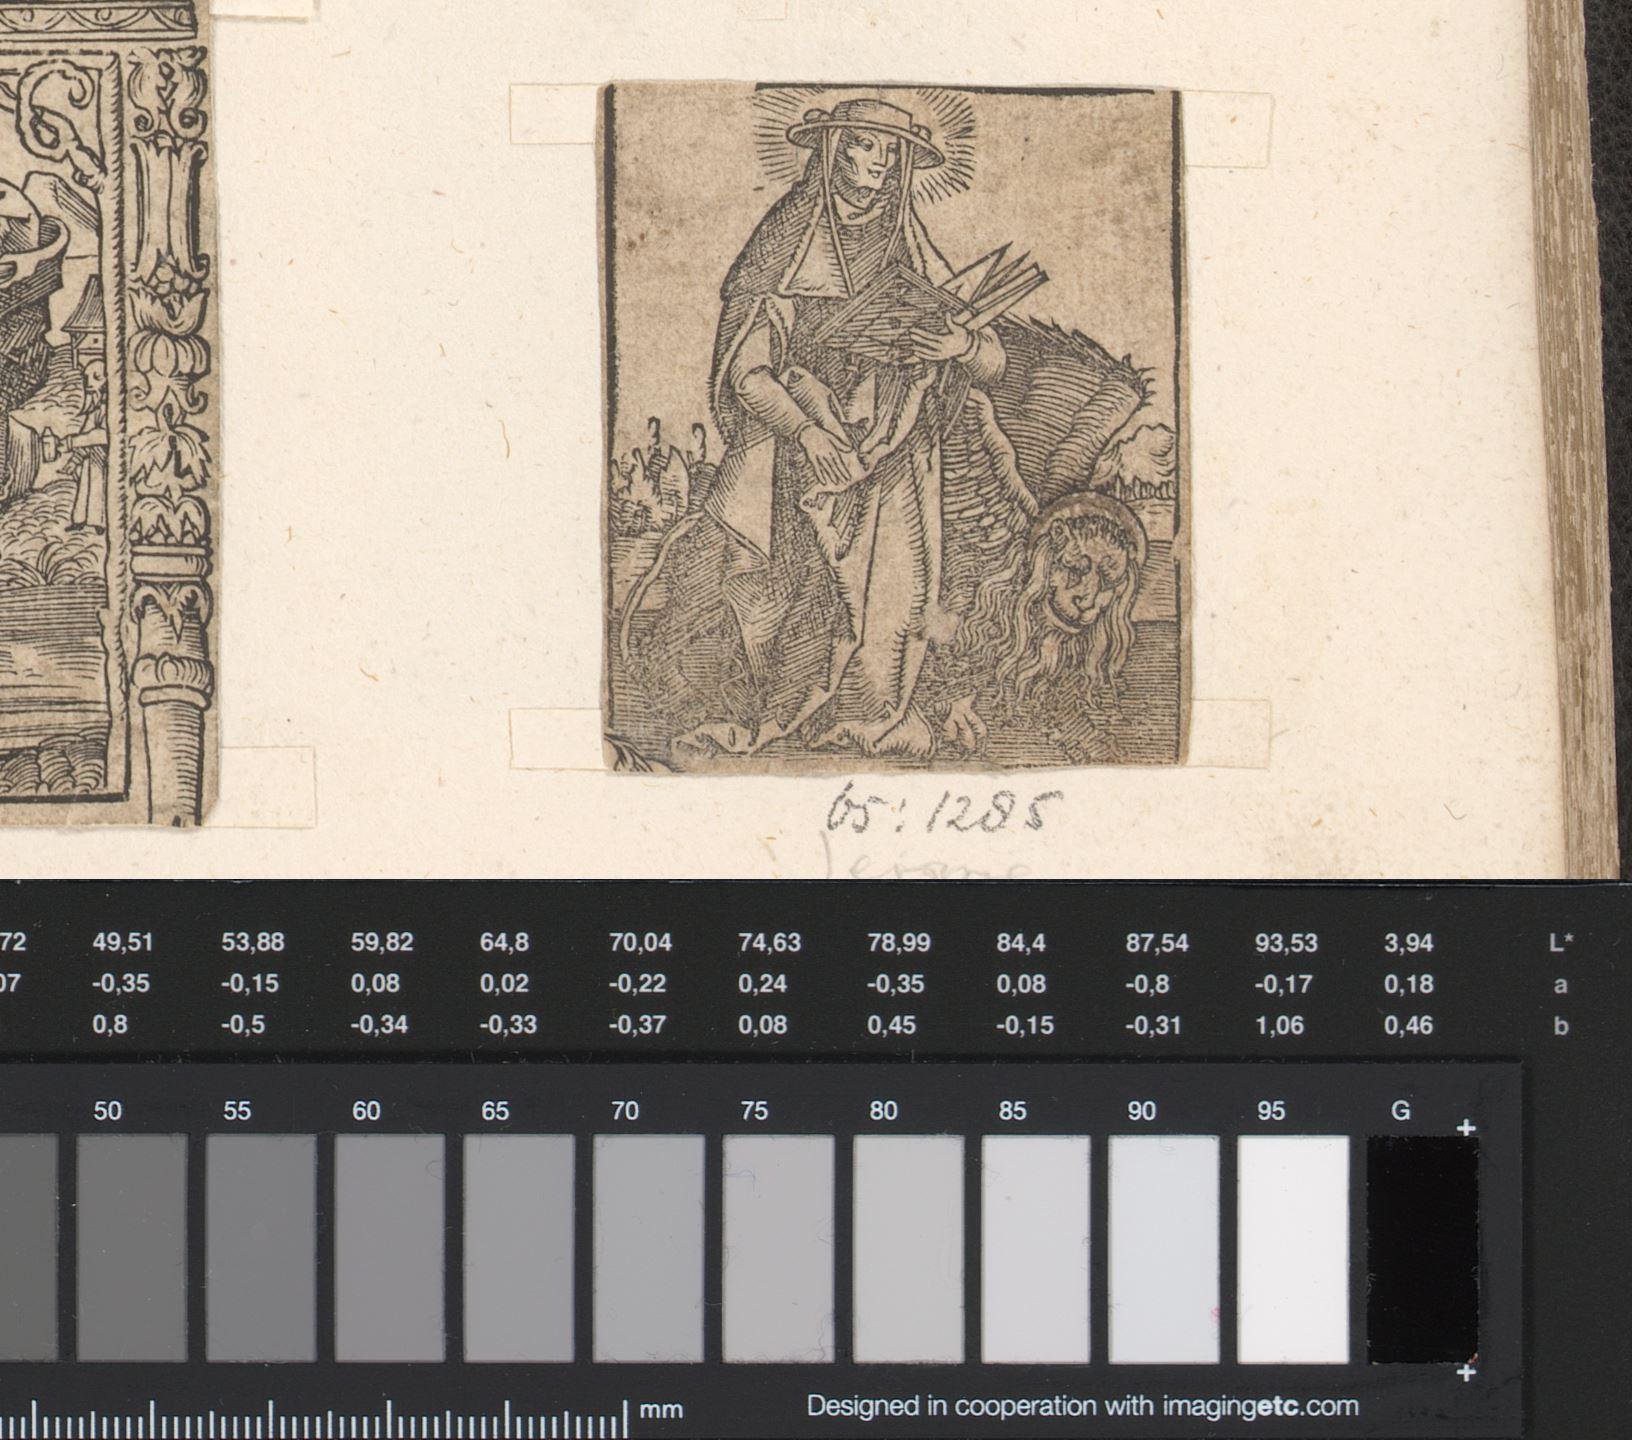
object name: book illustration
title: Kerkvader Hieronymus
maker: erhard schön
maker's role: draughtsman, print maker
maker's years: 1491-1542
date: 1500-1520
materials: paper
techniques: woodcut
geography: nuremberg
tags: the monk and hermit jerome (hieronymus); possible attributes: book, cardinal's hat, crucifix, hour-glass, lion, skull, stone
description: Hieronymus staande met een opengeslagen boek in de hand. Naast hem de leeuw. Prent maakt deel uit van een album.